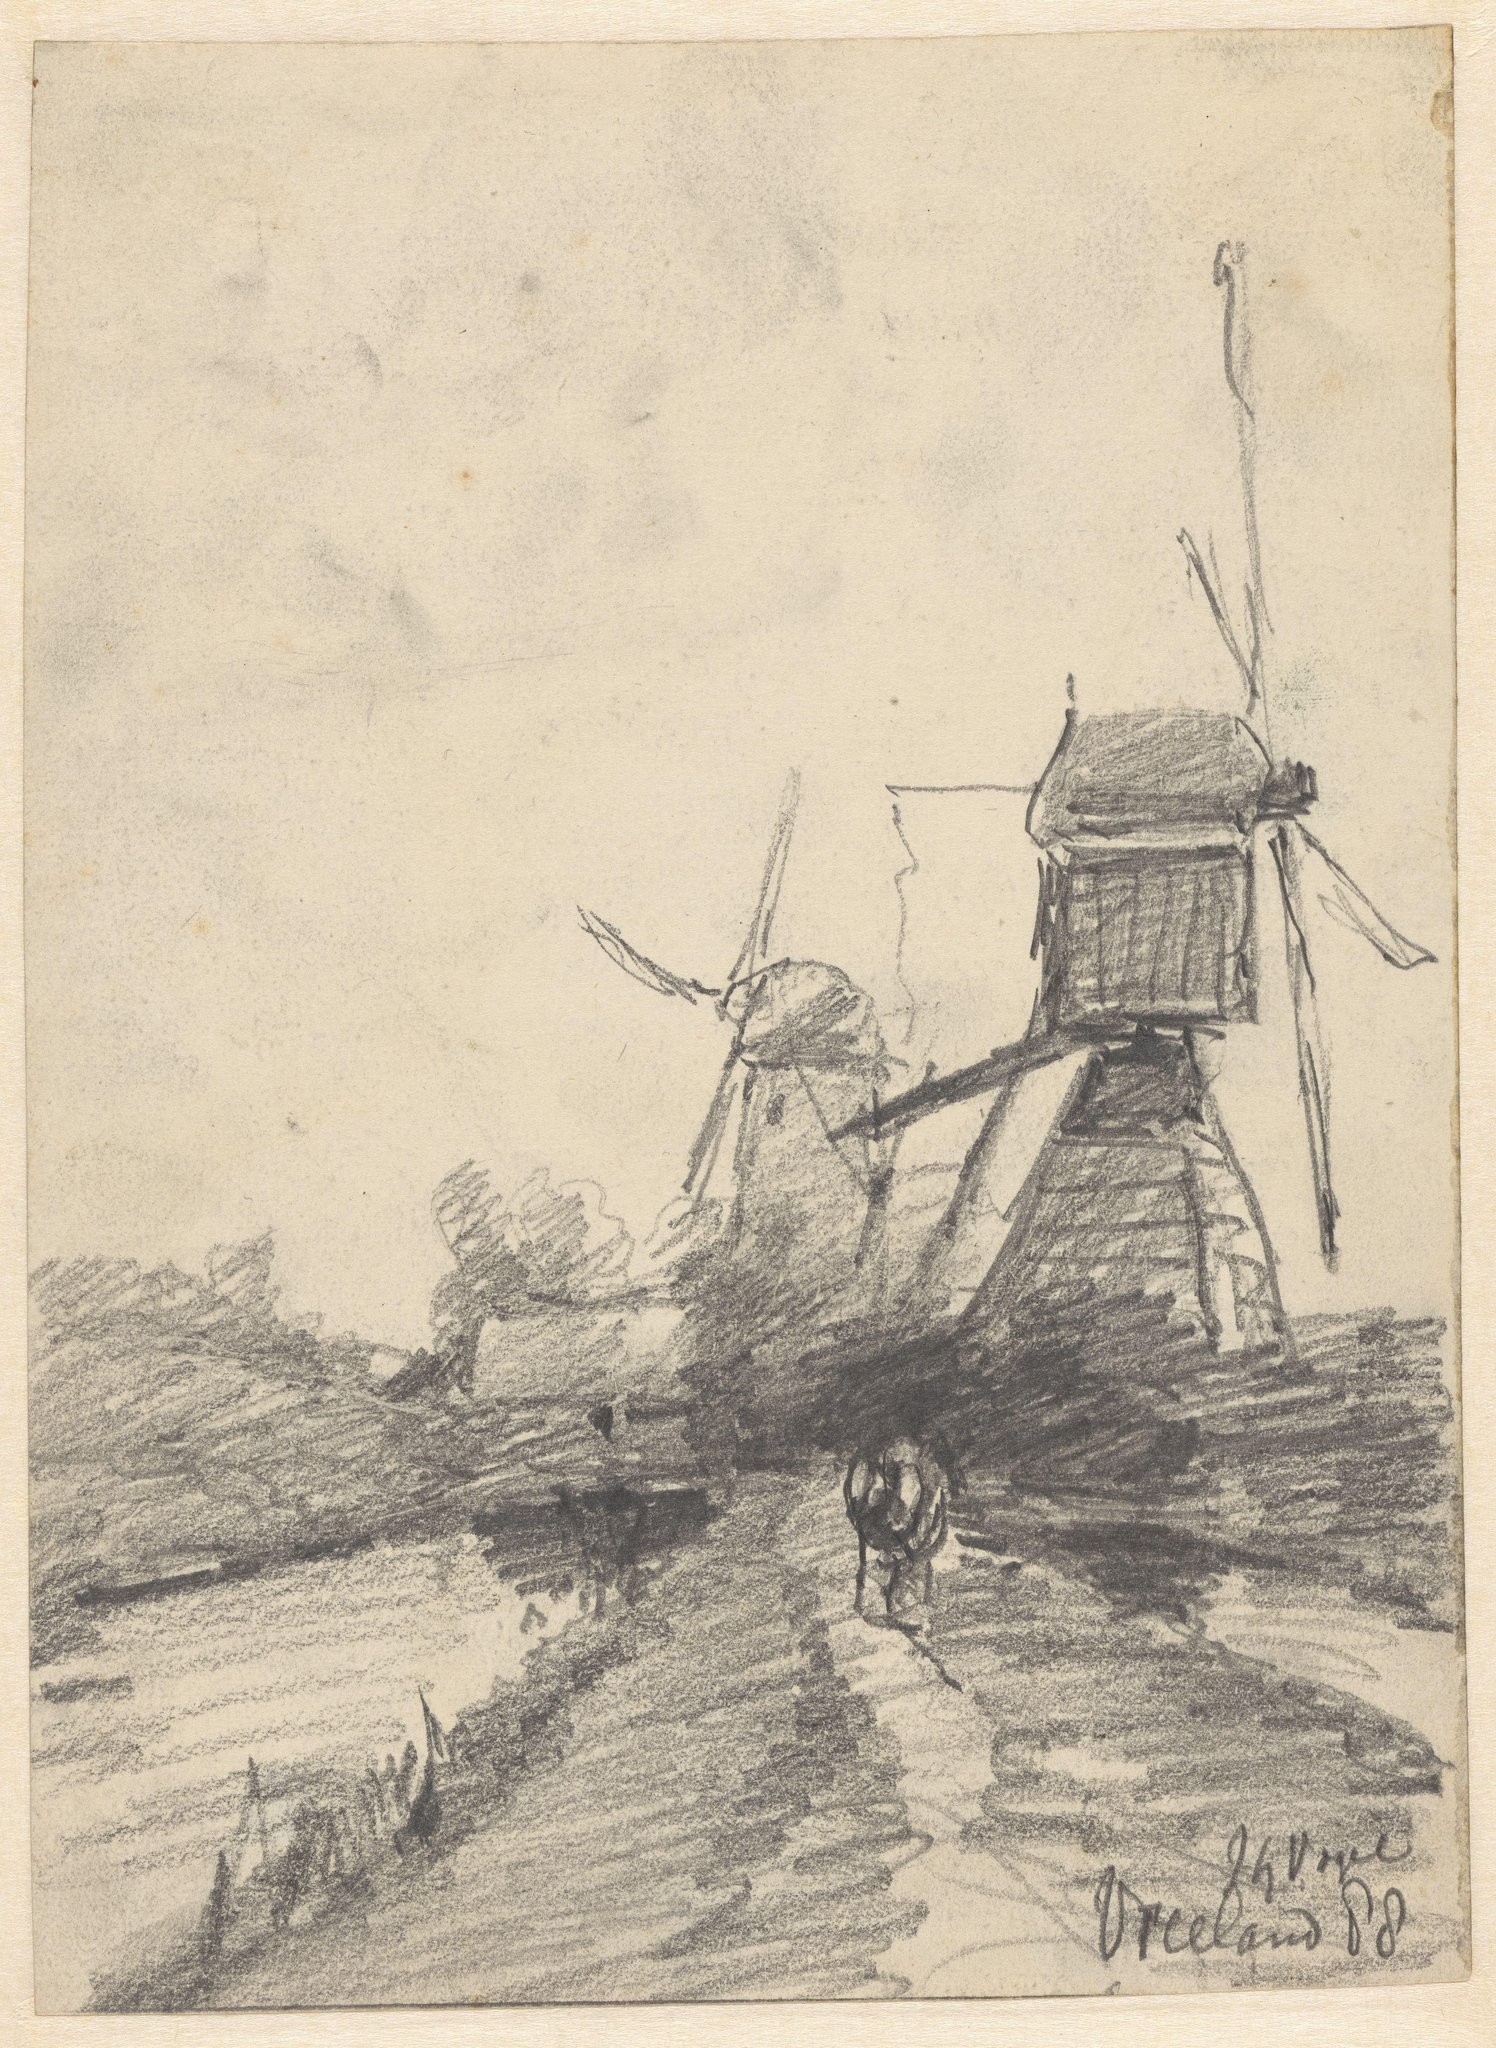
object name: drawing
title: Twee molens langs het water te Vreeland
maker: johannes gijsbert vogel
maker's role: draughtsman, painter, print maker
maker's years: 1828-1915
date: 1888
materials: paper, pencil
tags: landscapes with waters, waterscapes, seascapes (in the temperate zone), windmill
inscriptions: date and inscription: ‘Vreeland 88’, collector's mark: Lugt 1181b